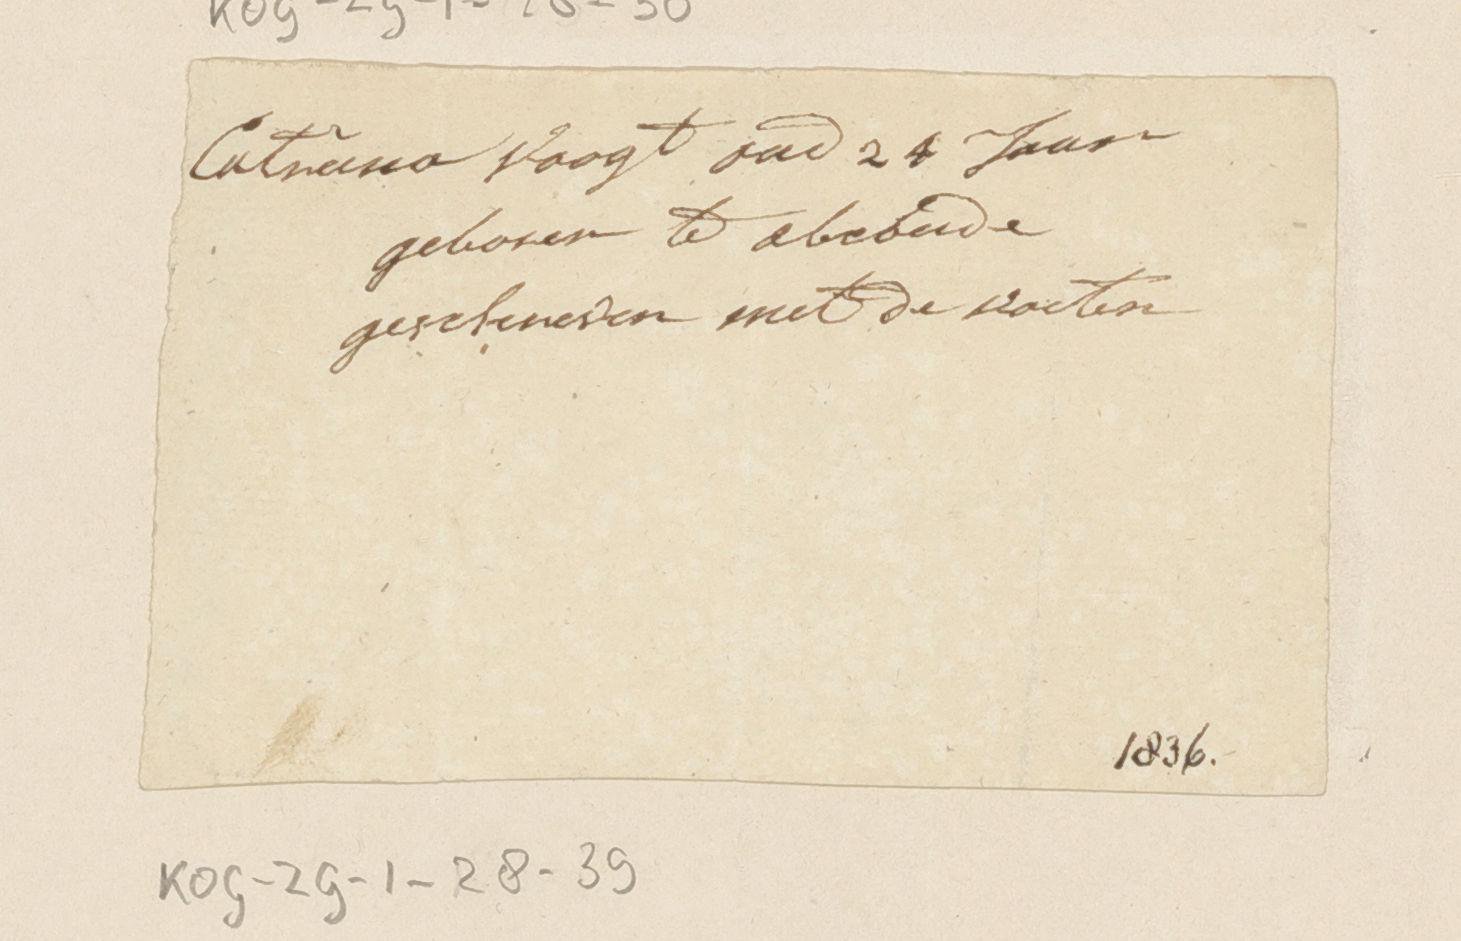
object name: manuscript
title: Brief van C. Voogt, geschreven met diens voeten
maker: Anonymous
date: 1836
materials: ink, paper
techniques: pen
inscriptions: stamp, collector's mark: Lugt 1641, stamp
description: Brief van C. Voogt, geschreven met diens voeten. Deze persoon 24 jaar oud op het moment van schrijven. Onderwerpsrubrieken binnen de Atlas Zeden en Gewoonten: Zeden en Gewoonten in Engeren Zin. Volksleven. Volksfeesten. Kermistypen, wondermenschen en dergelijken.